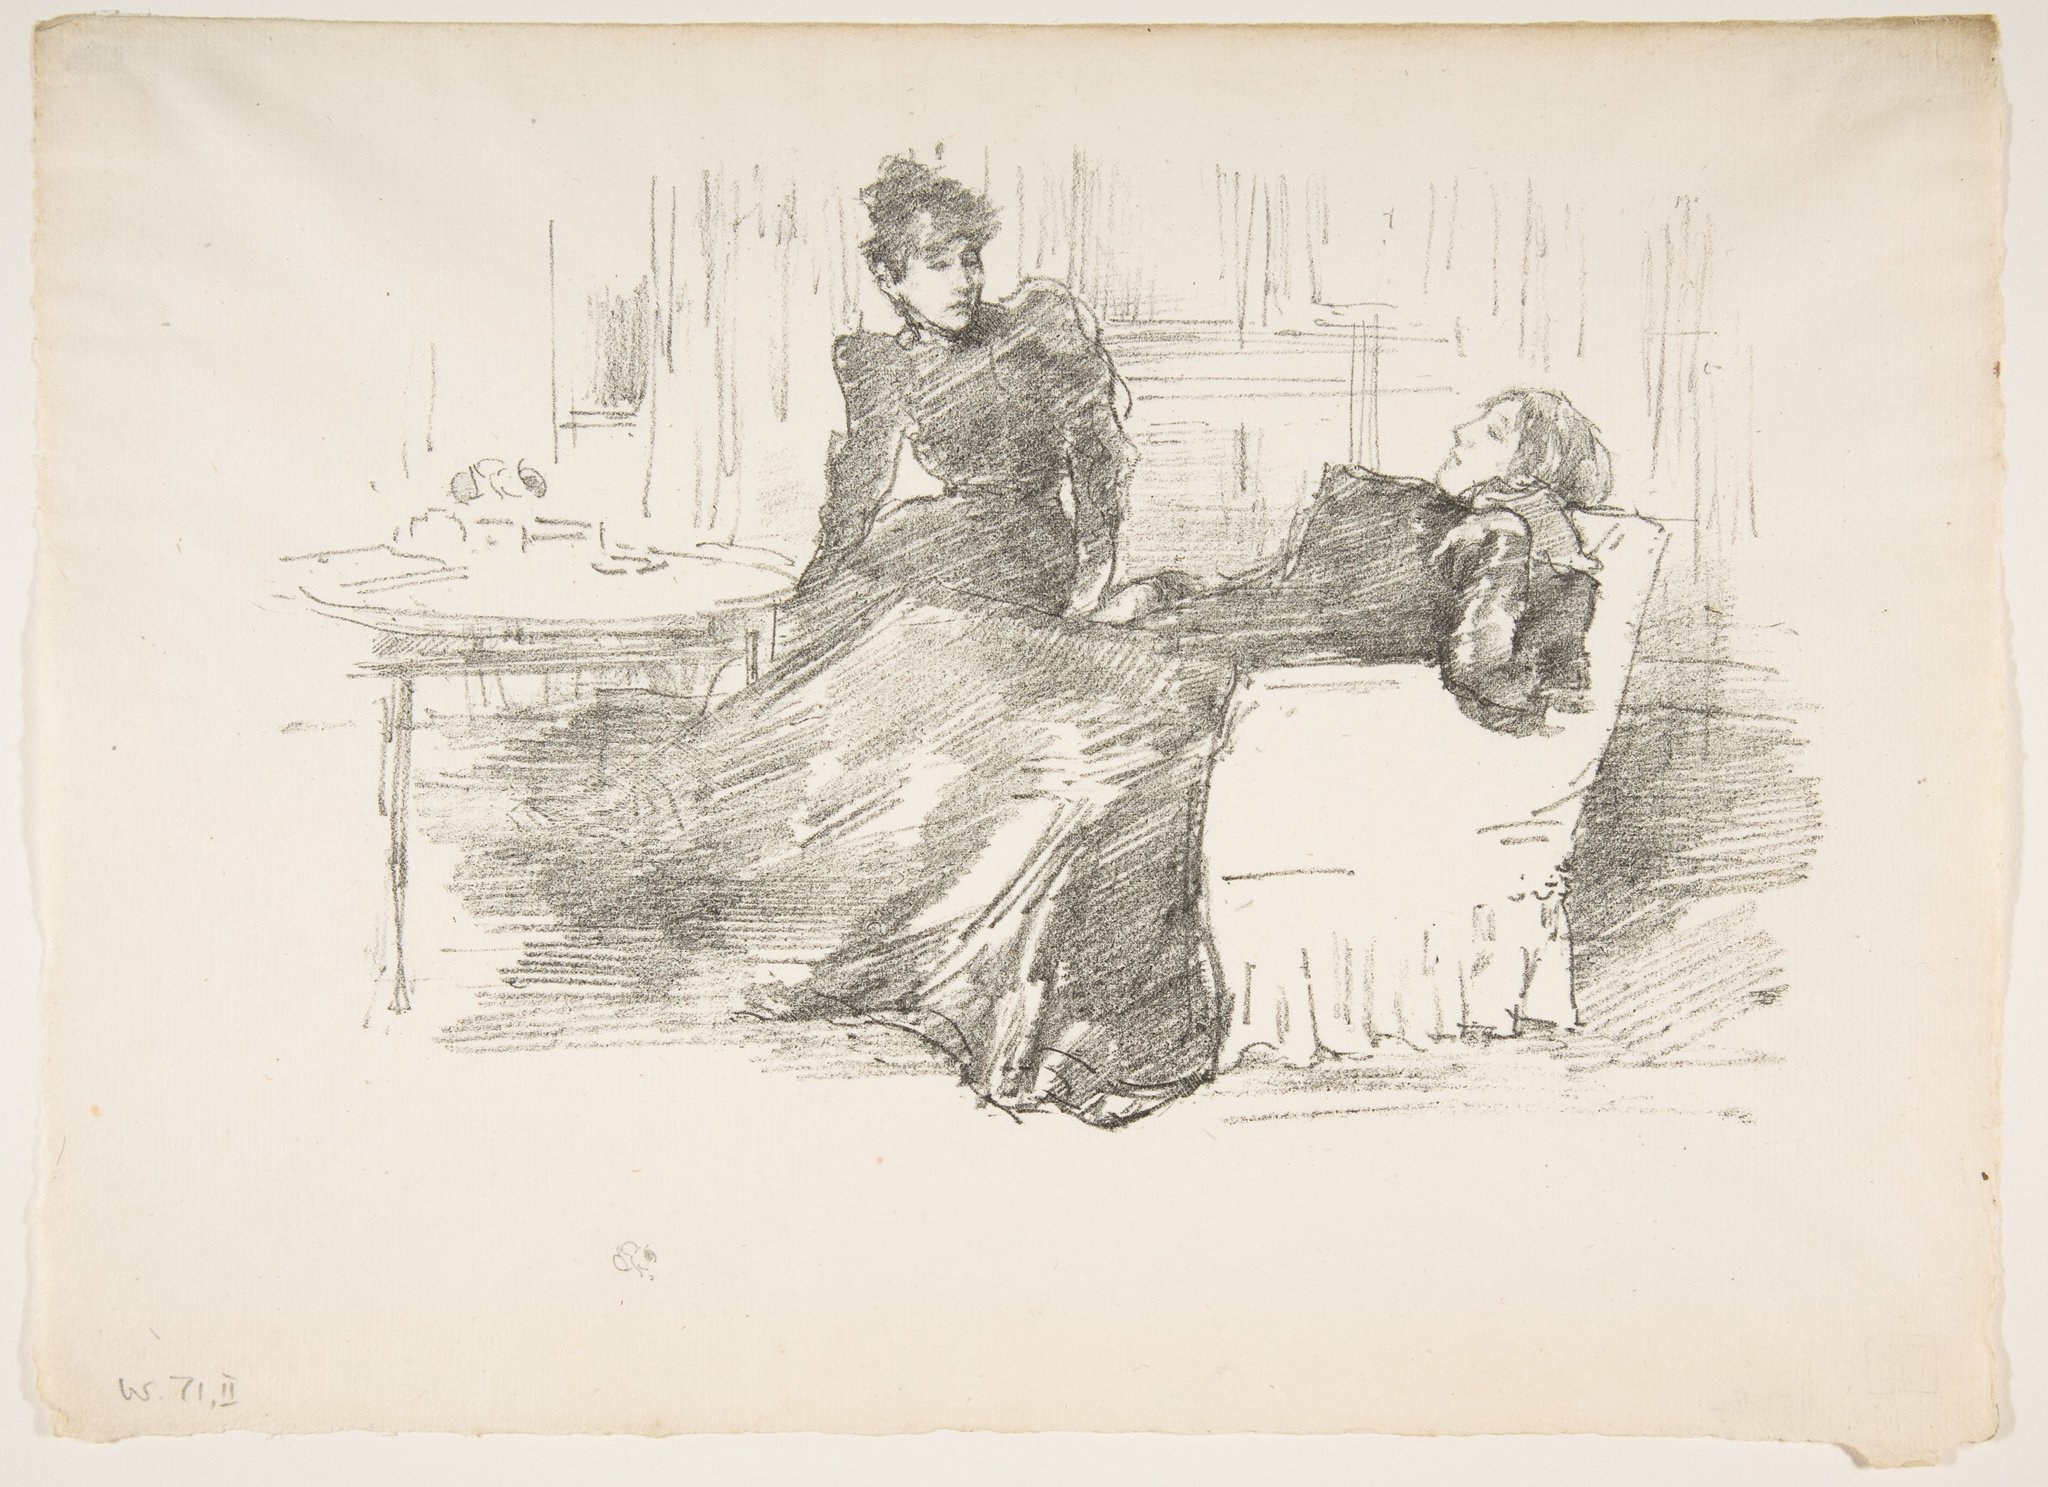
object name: print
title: The Sisters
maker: james mcneill whistler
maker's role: artist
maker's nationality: american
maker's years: 1834-1903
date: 1894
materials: ink, paper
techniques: printing, scraping, lithography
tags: women